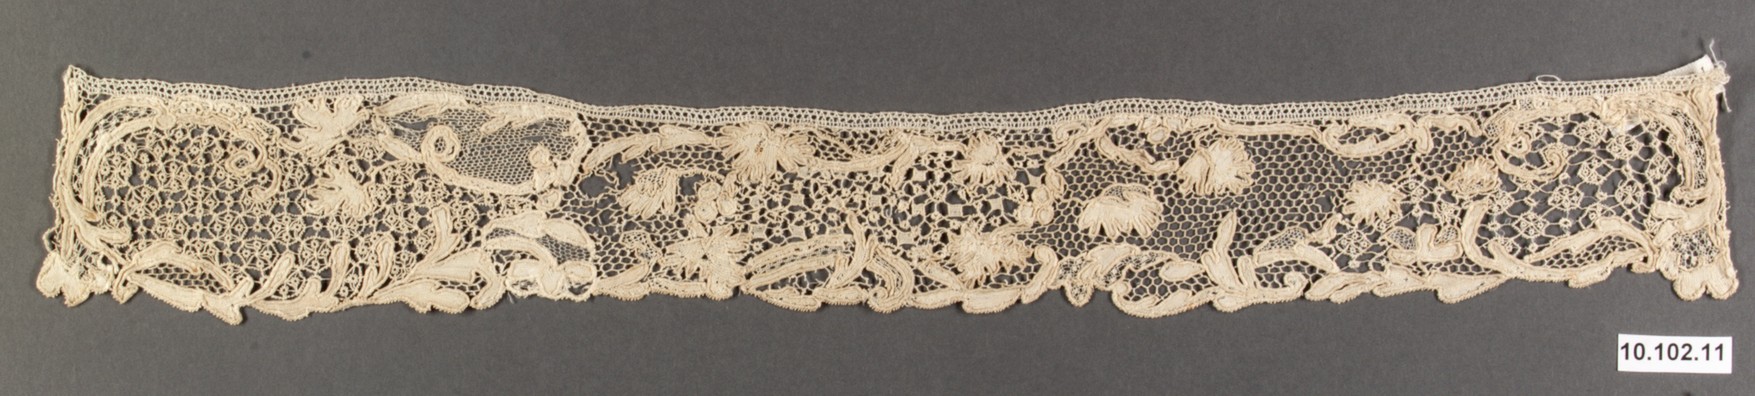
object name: lace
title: Piece of needle lace (one of a pair)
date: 1701-1733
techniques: lace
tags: flowers